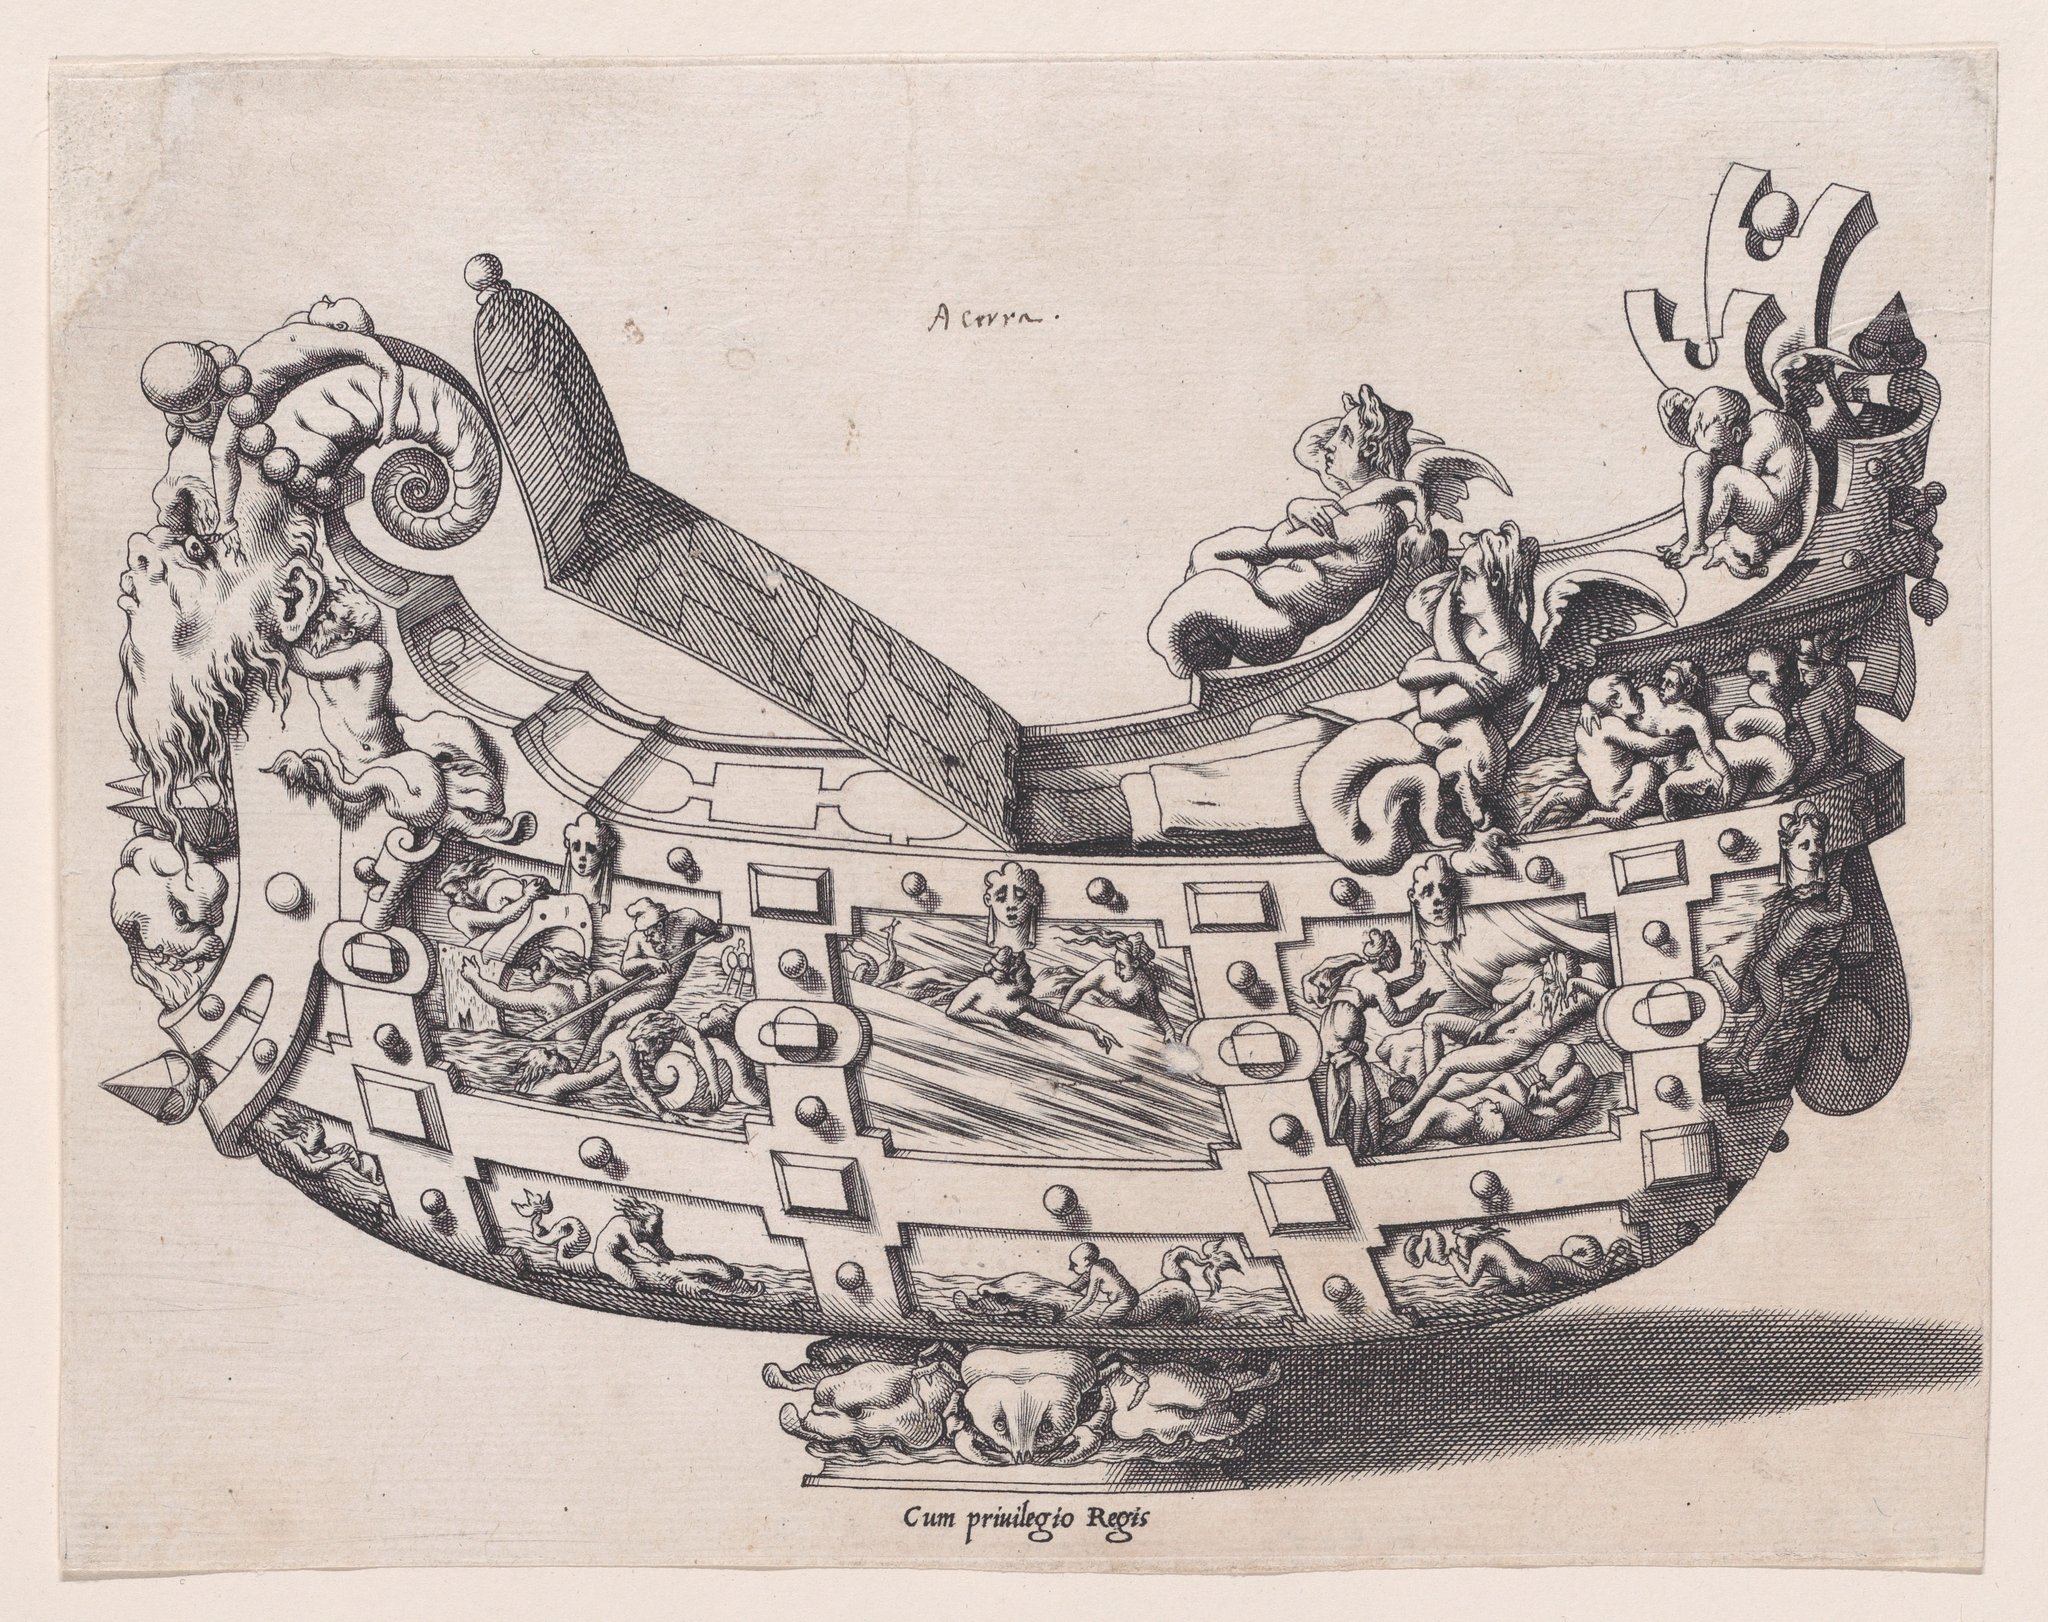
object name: print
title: Container for the Royal Napkins (Nef)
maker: rené boyvin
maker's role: artist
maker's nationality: french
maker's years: 1525-1598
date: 1525-1600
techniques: engraving